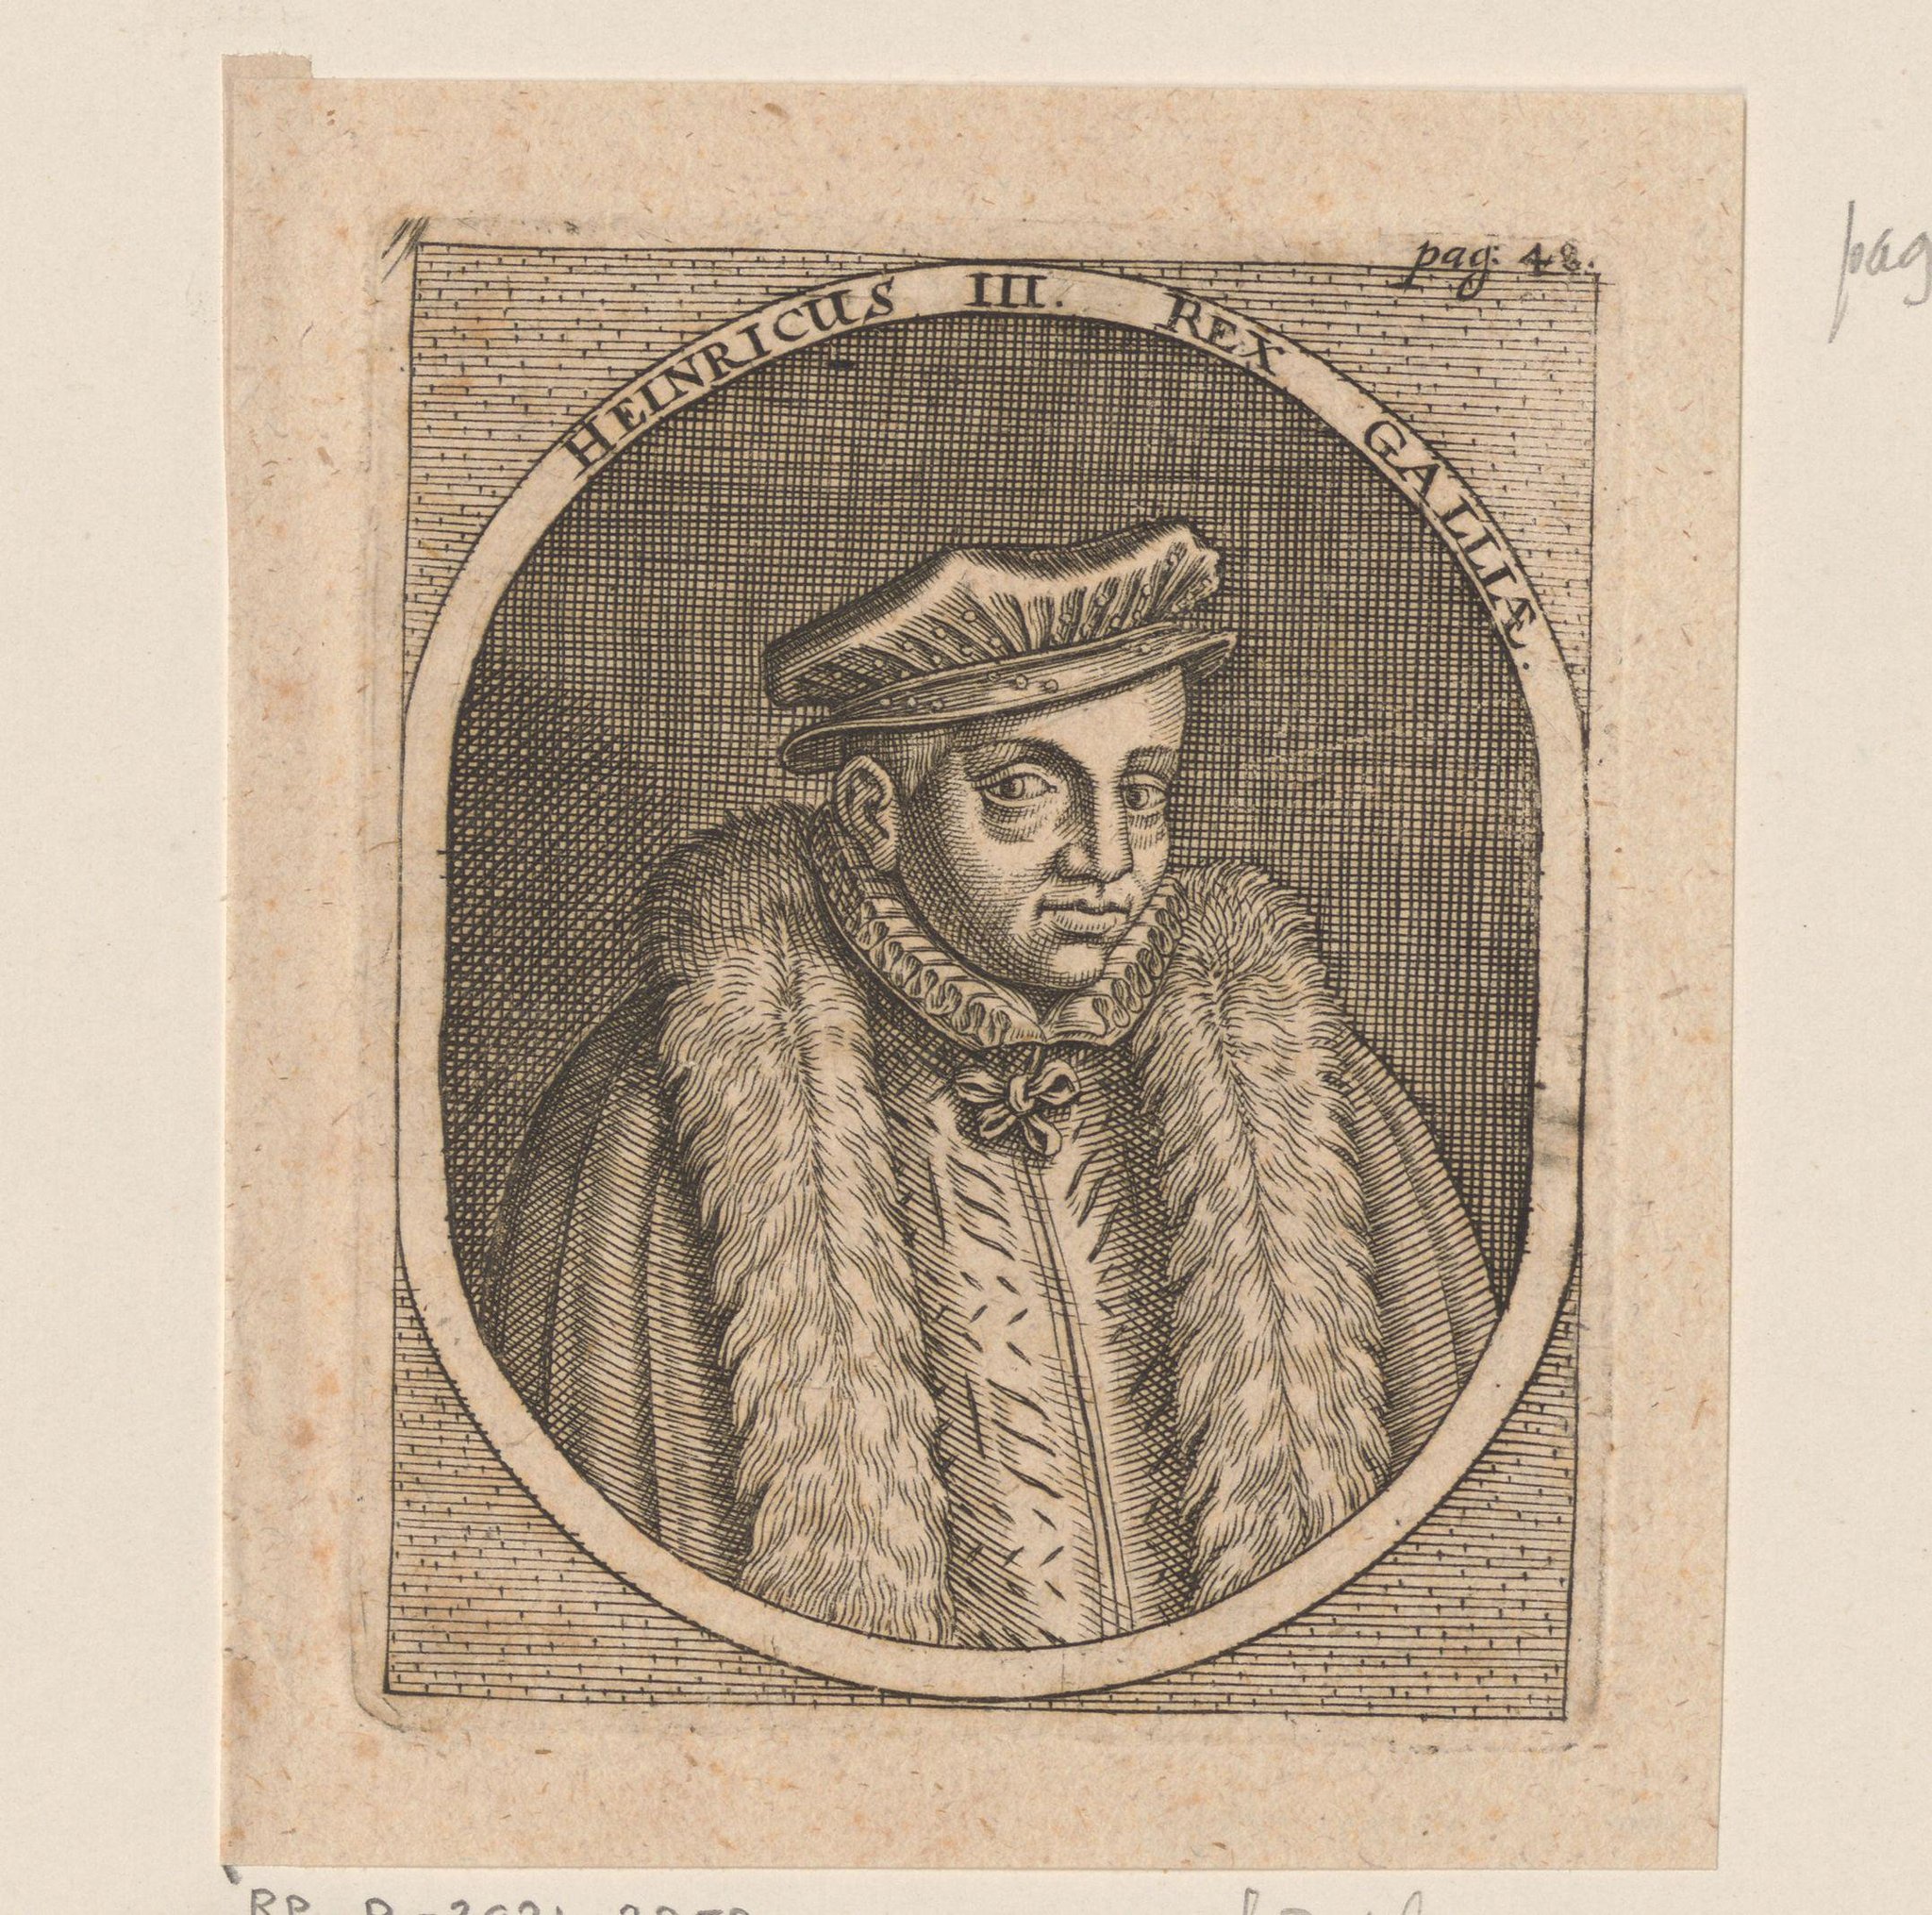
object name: book illustration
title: Portret van Hendrik III, koning van Frankrijk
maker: Anonymous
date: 1650-1749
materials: paper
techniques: engraving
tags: hendrik iii (koning van frankrijk), historical persons, king